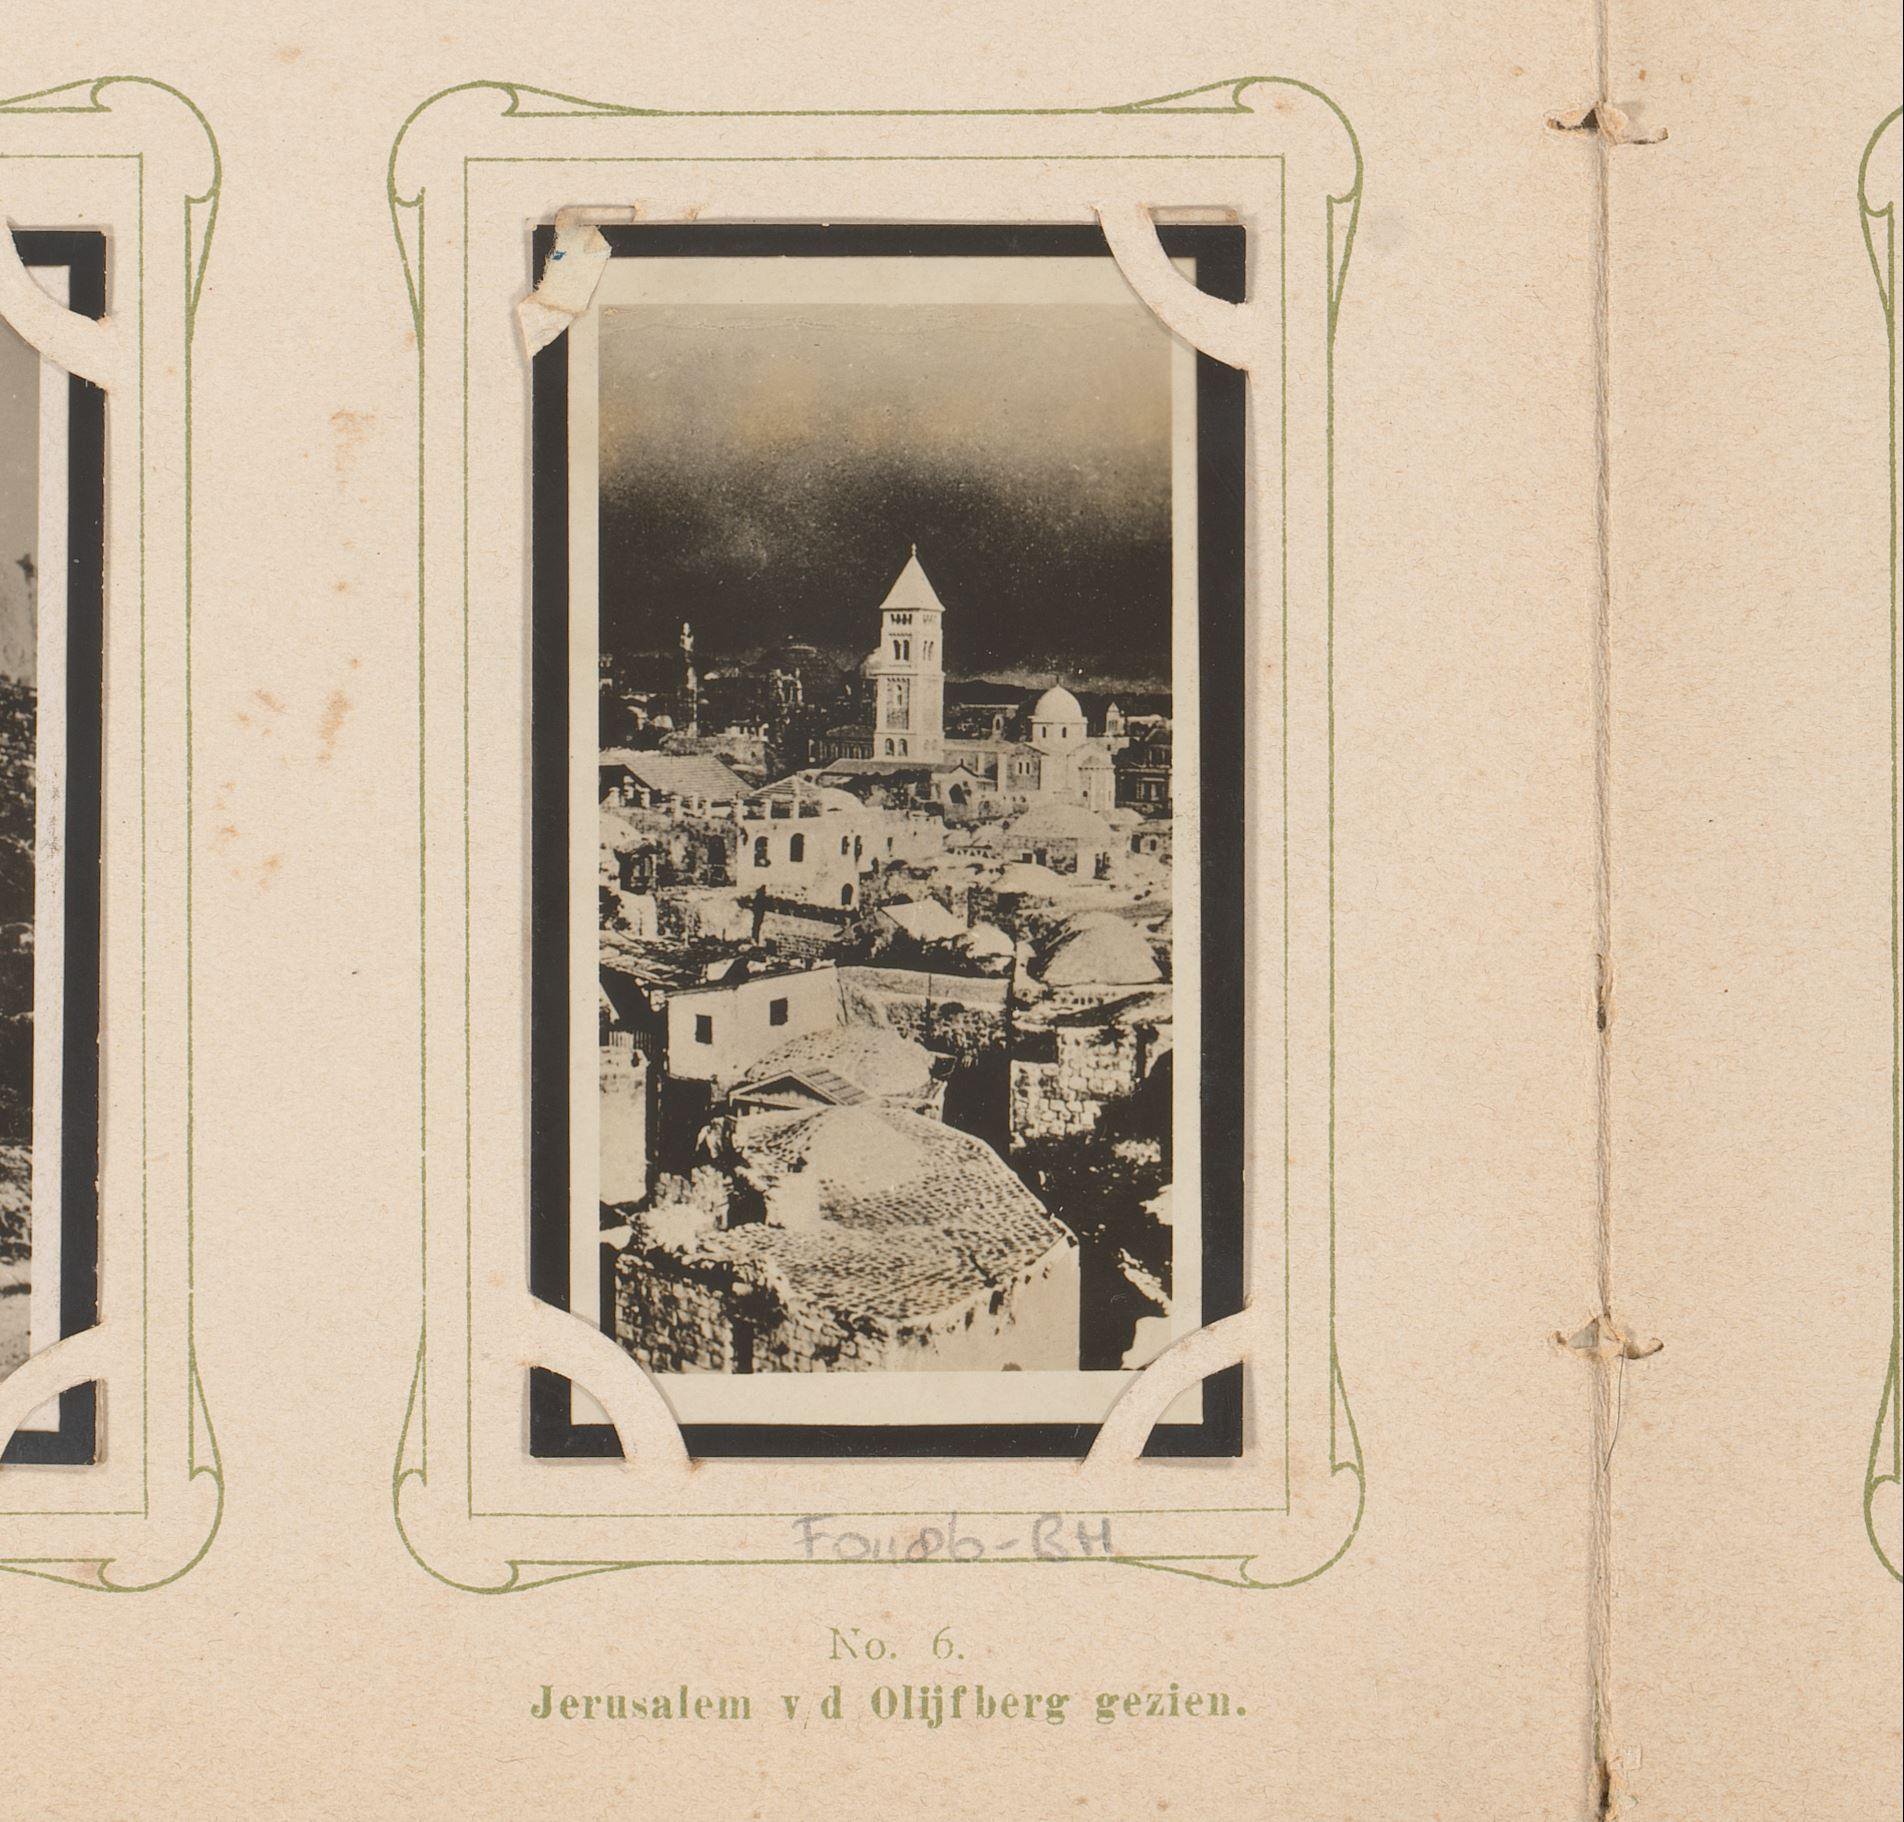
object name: photograph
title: Gezicht op Jeruzalem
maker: Anonymous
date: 1904-1905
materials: photographic support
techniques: gelatin silver print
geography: jerusalem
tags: city-view in general; 'veduta'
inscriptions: inscription: ‘No. 6./ Jerusalem v/d Olijfberg gezien.’